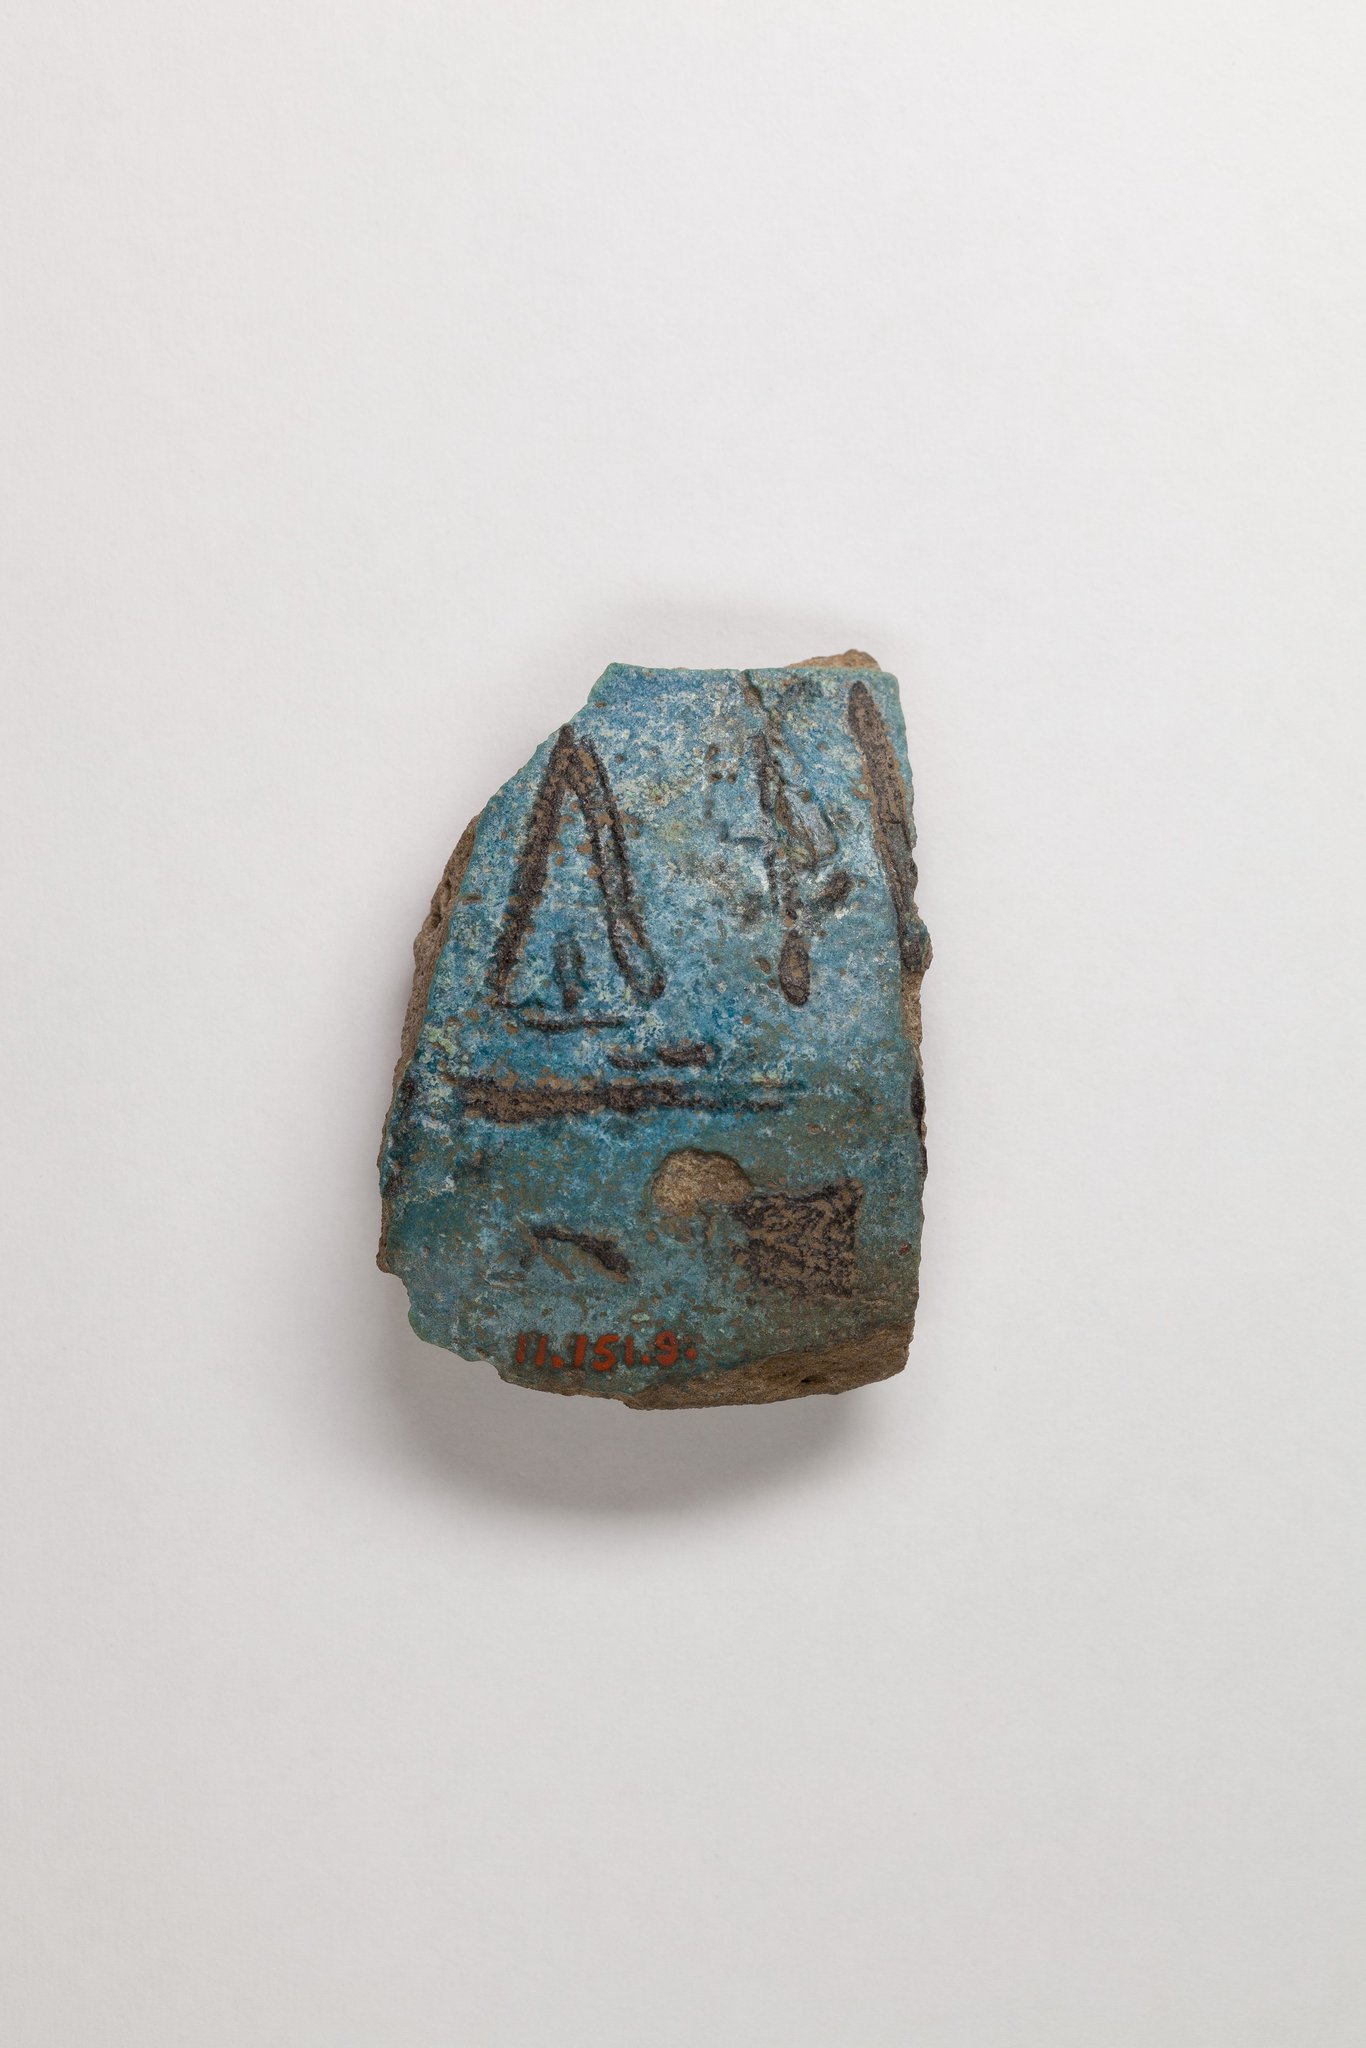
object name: vase fragment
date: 1981-1640 BCE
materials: faience, paint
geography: egypt